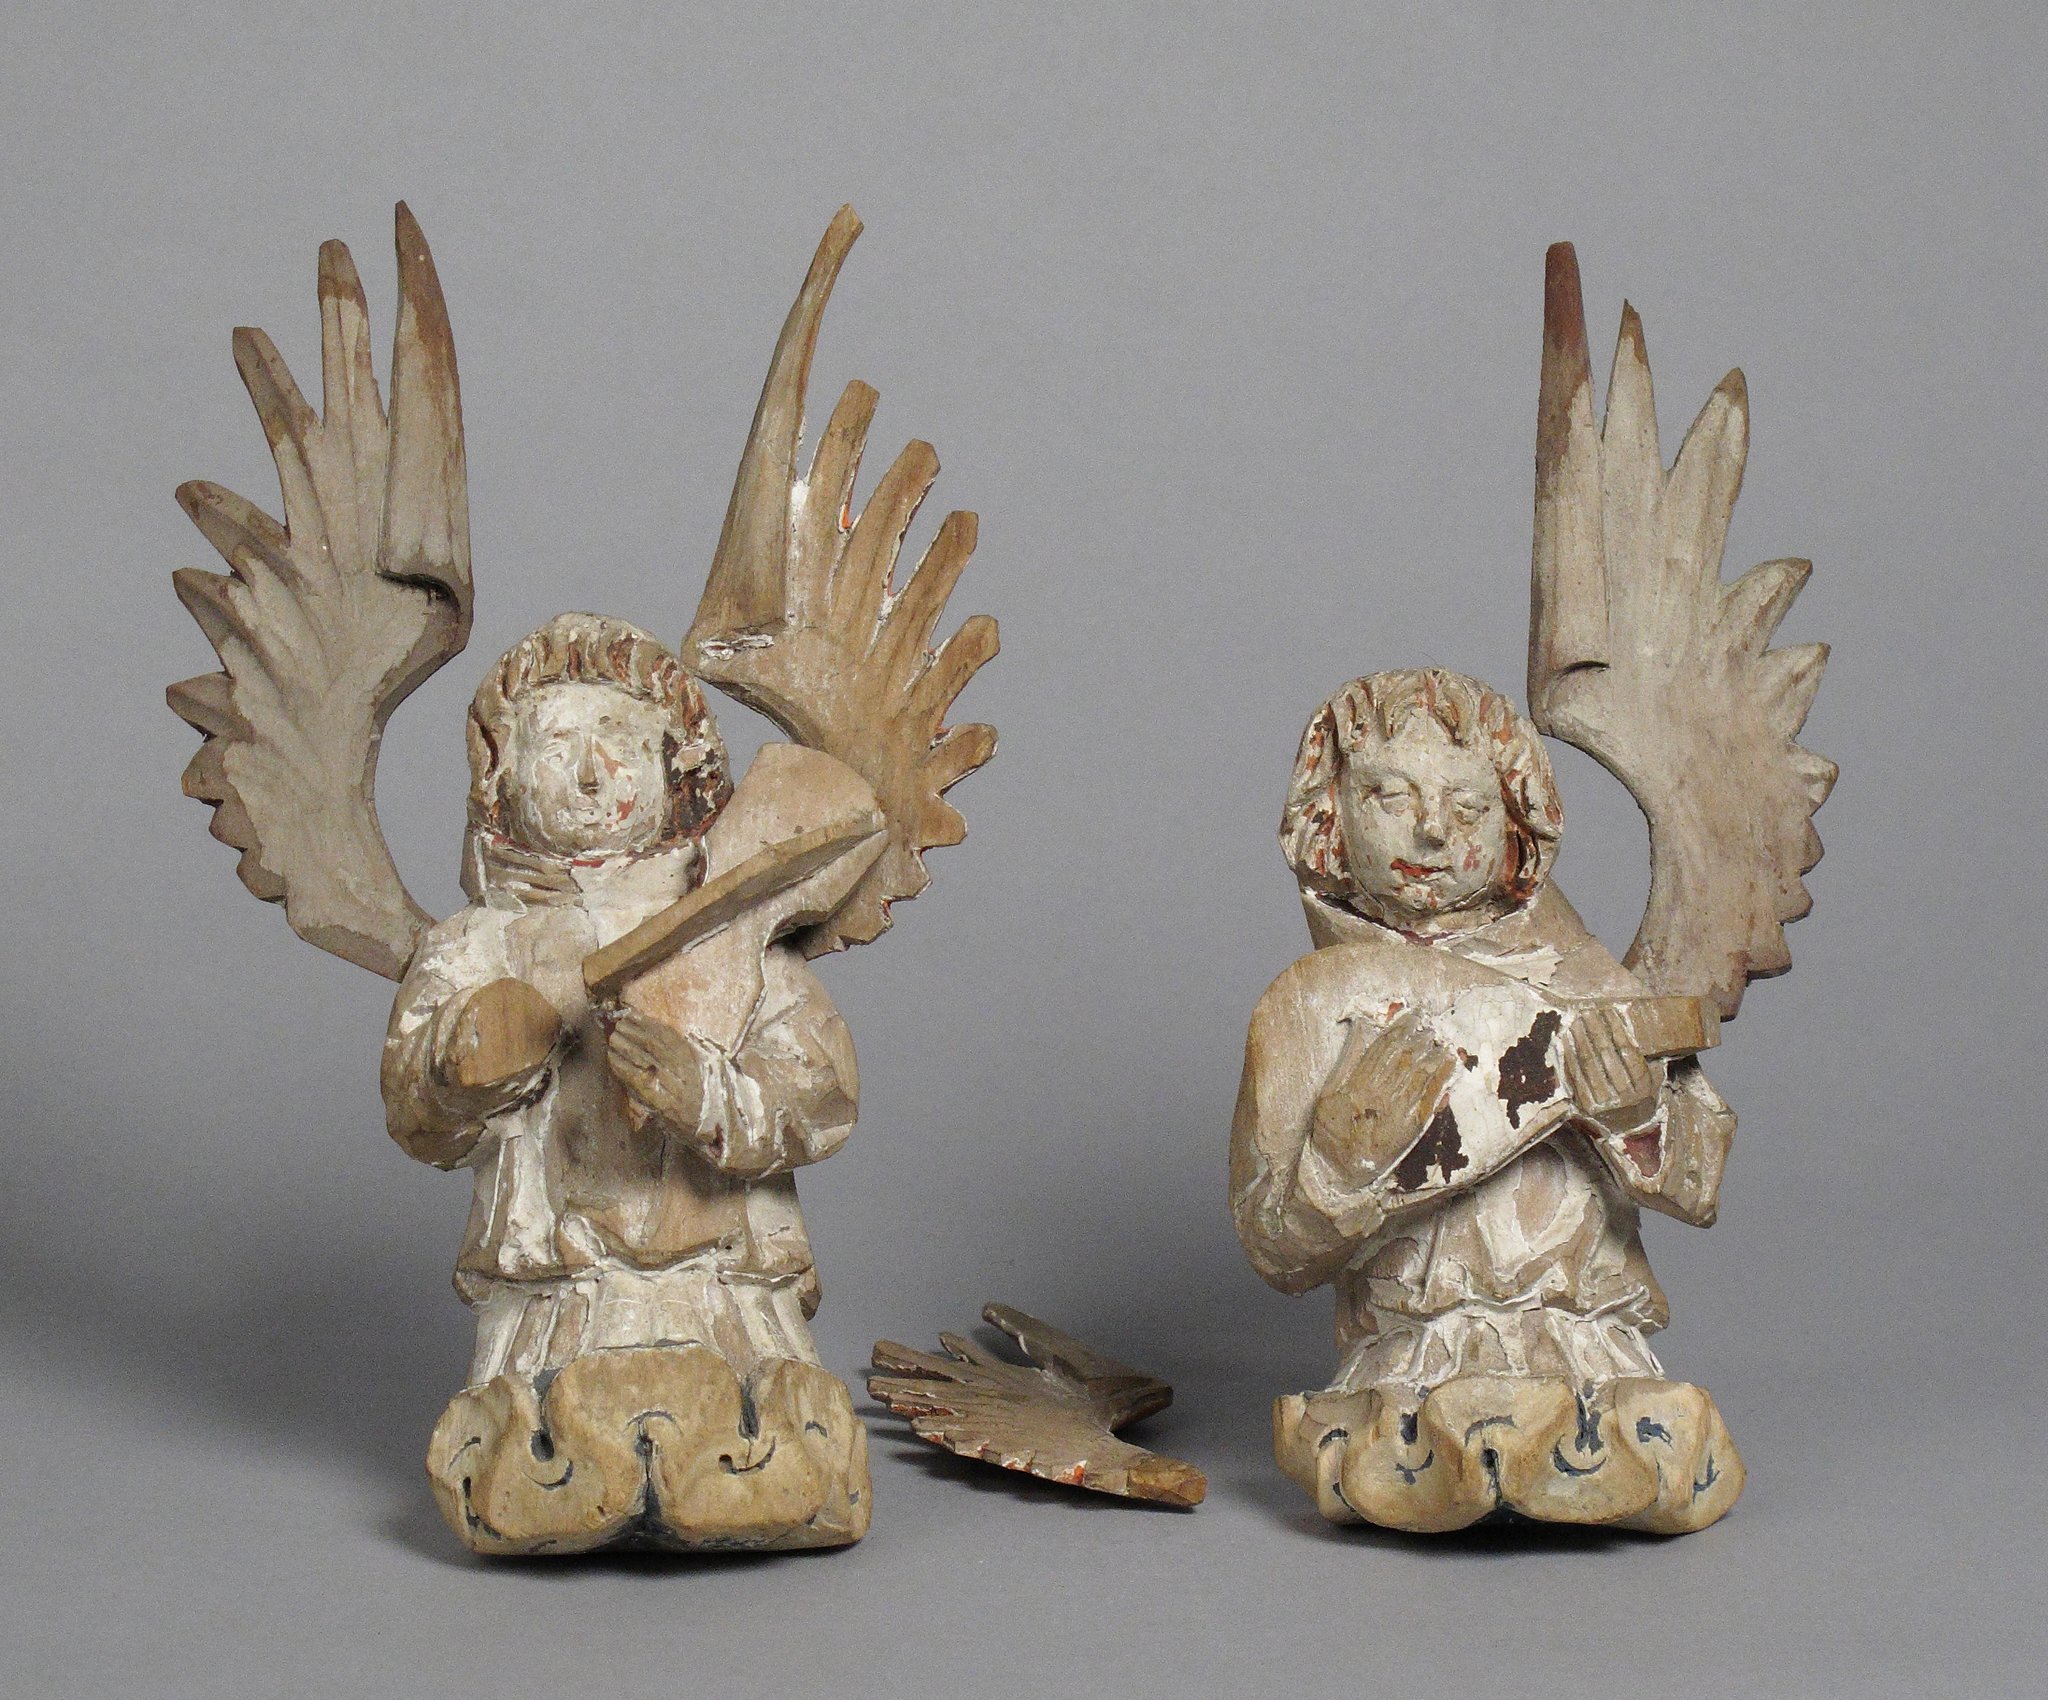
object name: relief statue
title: Angel Playing Instrument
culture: french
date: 1401-1500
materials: paint, wood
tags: musical instruments,angels